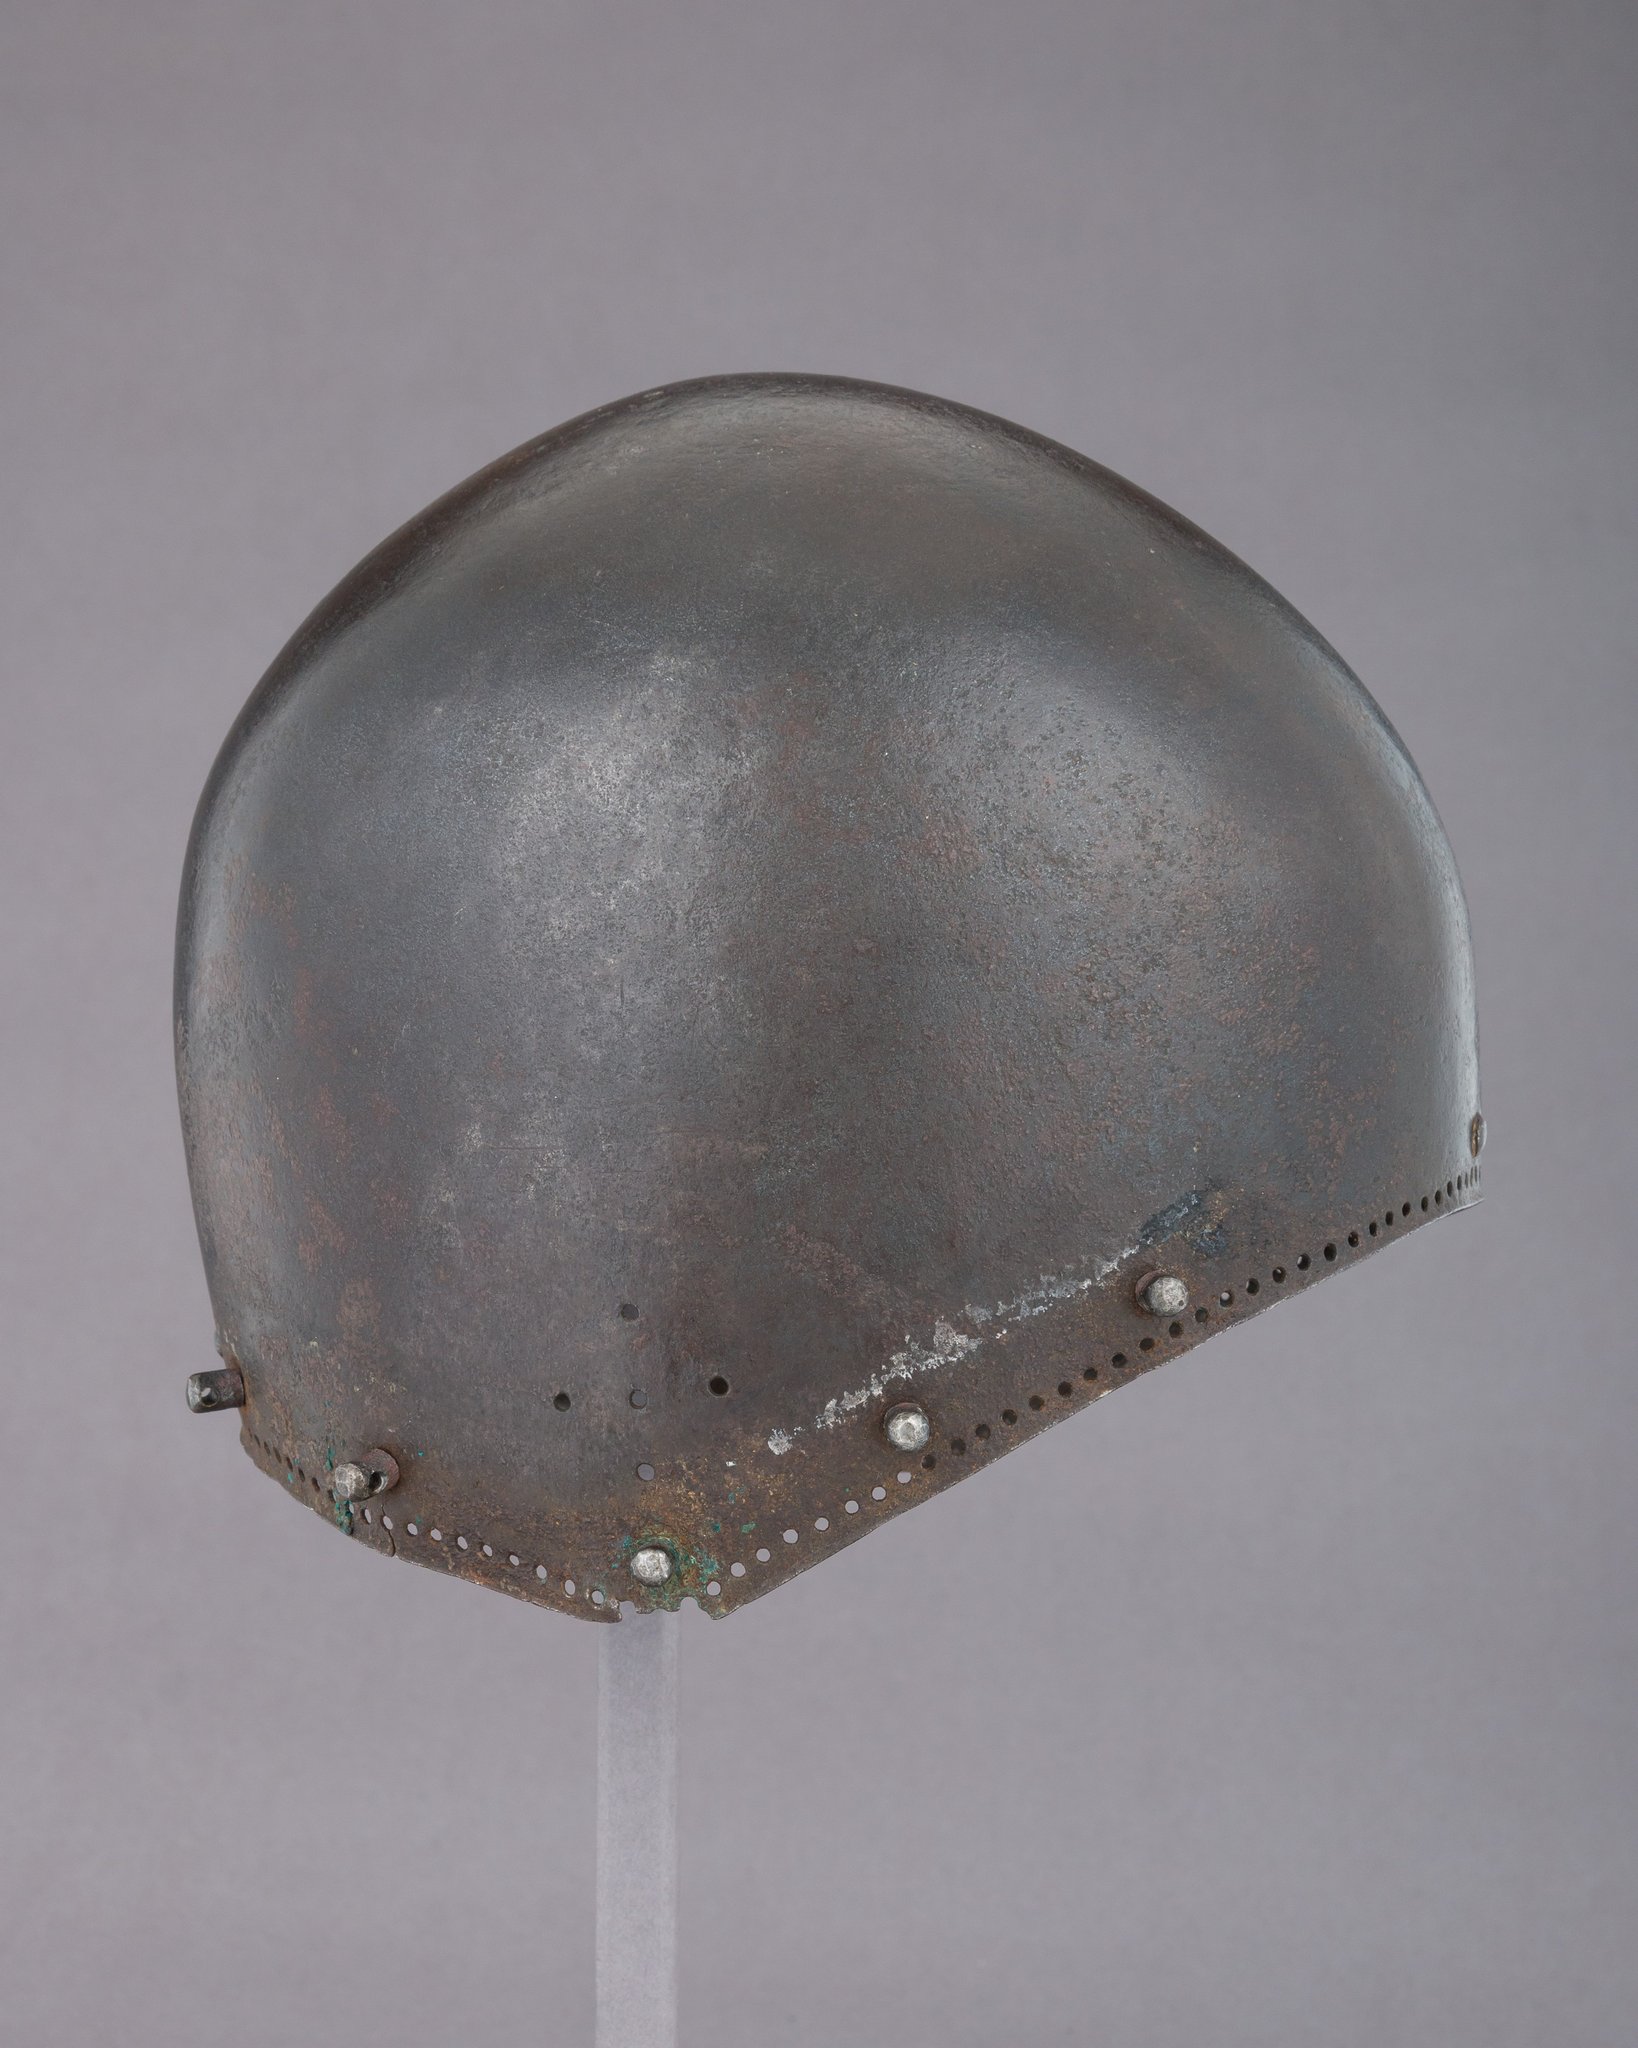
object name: bascinet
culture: german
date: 1325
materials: leather, steel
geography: germany